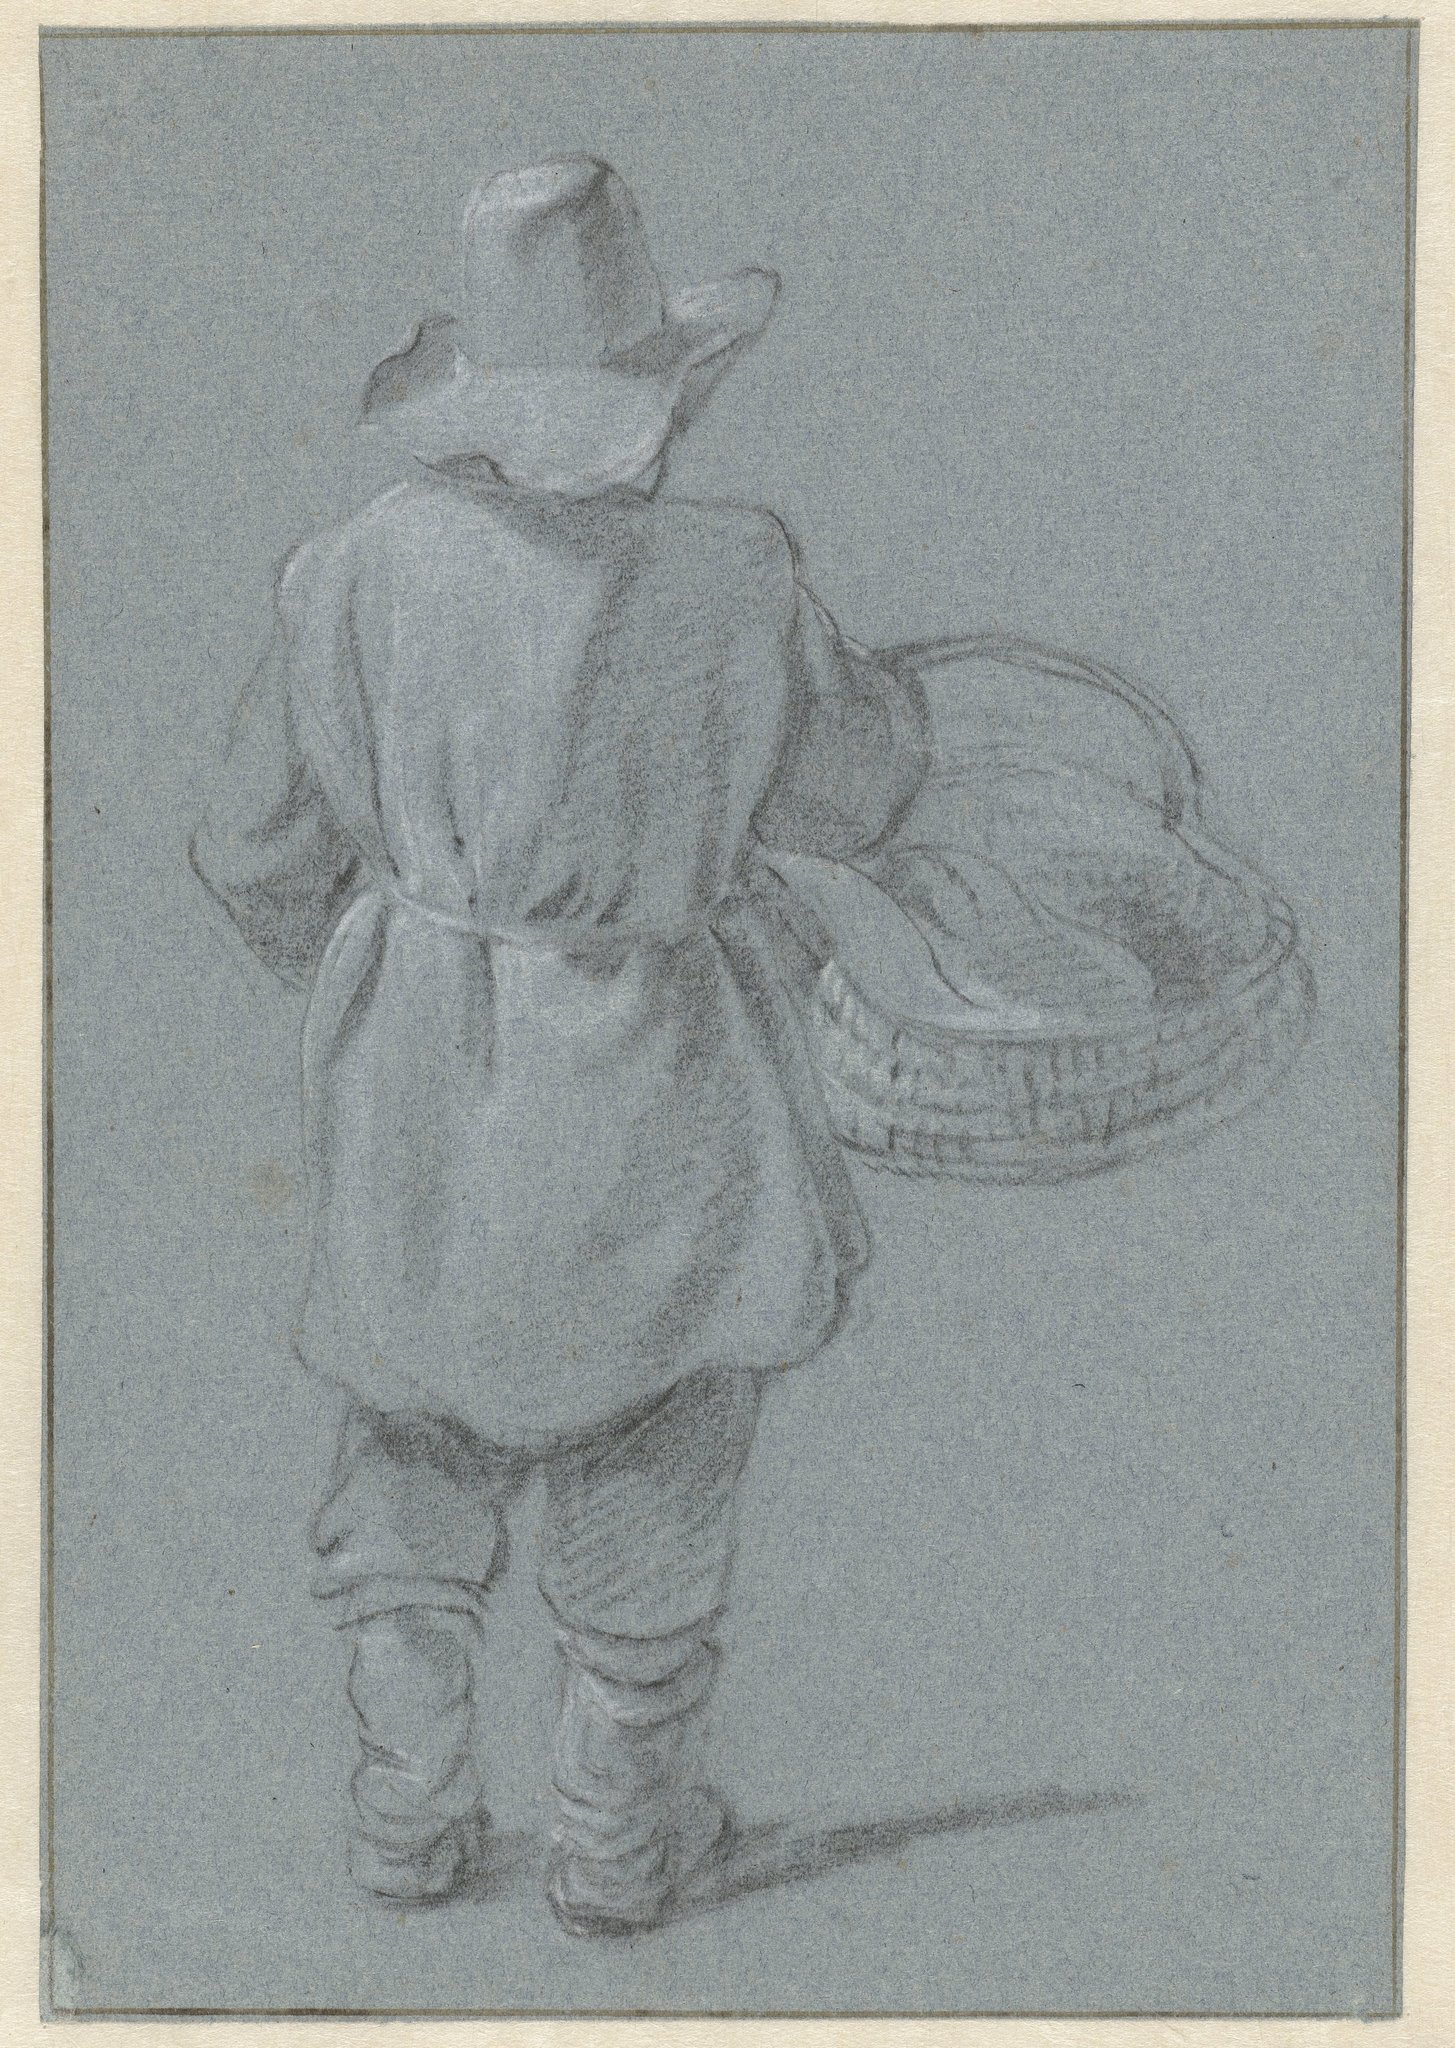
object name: drawing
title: Staande man met mand, op de rug gezien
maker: Anonymous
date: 1600-1699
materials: chalk, paper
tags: standing figure